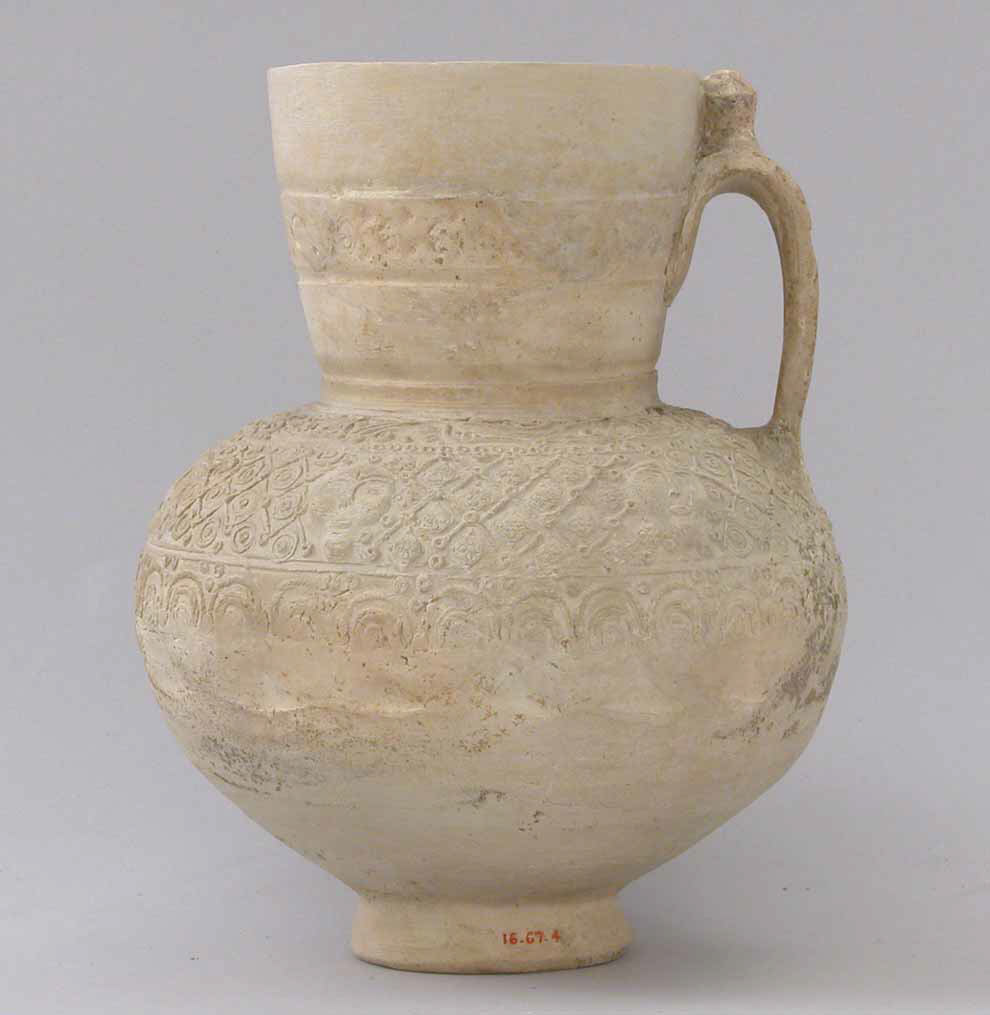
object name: jar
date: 1001-1200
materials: earthenware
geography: syria